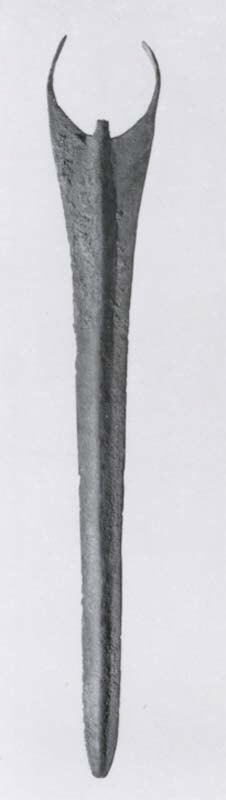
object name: dagger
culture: iranian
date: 800-601 BCE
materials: bronze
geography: northwestern iran, caspian region